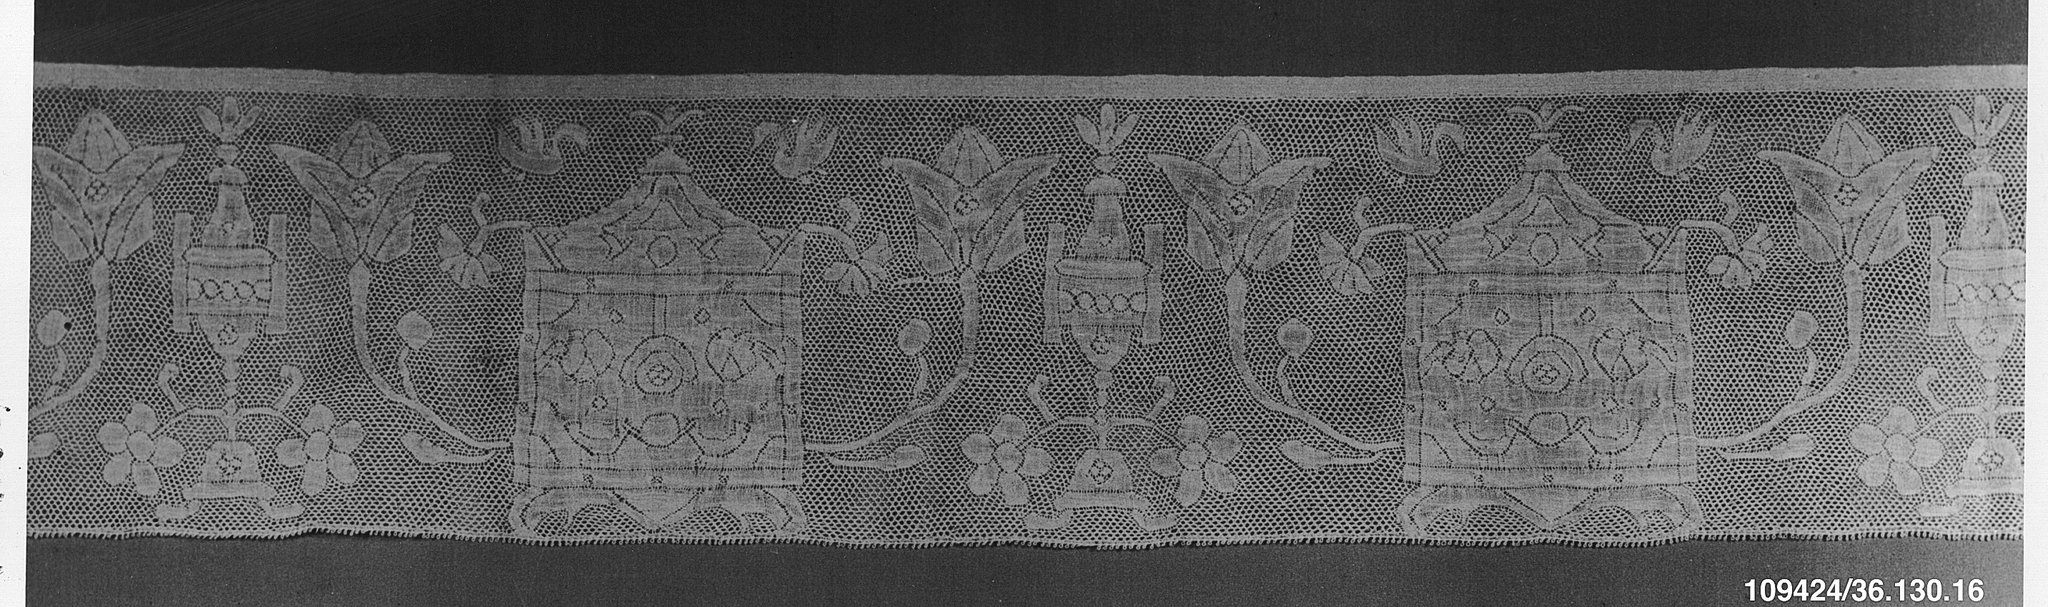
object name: border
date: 1701-1800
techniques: lace